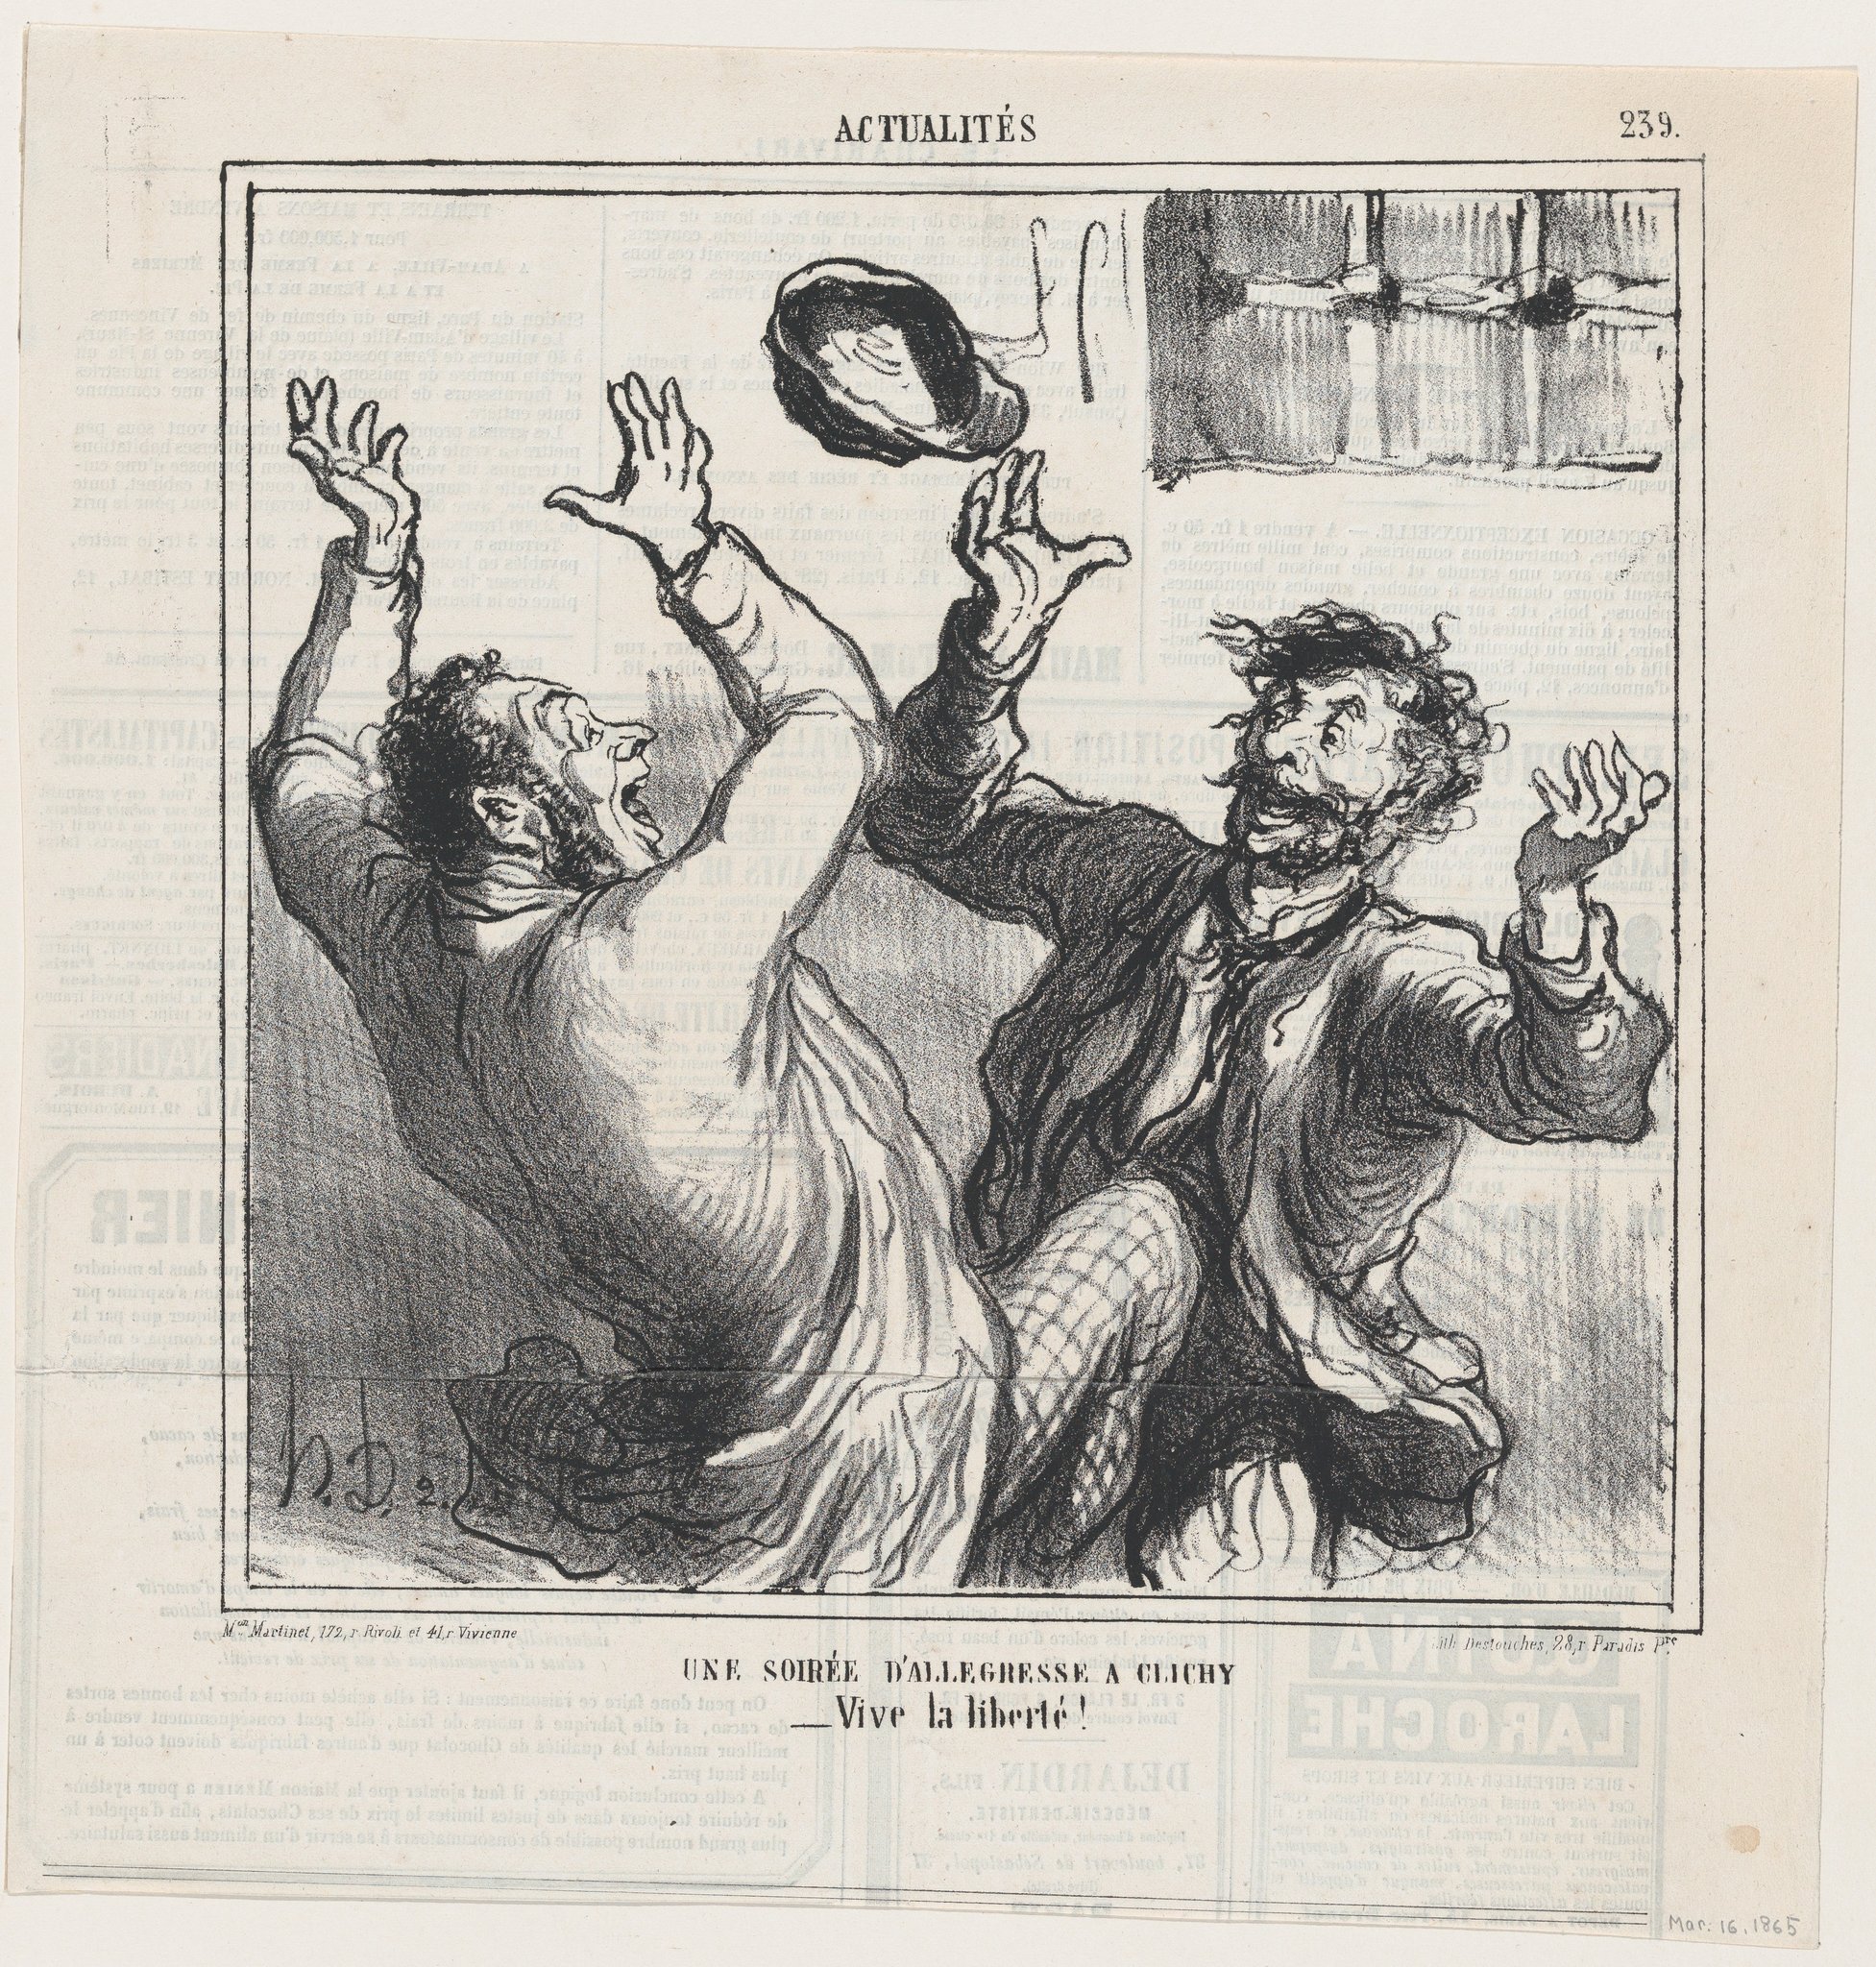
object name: print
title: A happy evening party in Clichy, from 'News of the day,' published in Le Charivari, March 16, 1865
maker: honoré daumier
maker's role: artist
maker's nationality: french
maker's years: 1808-1879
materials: paper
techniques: lithograph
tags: satire,happiness,men